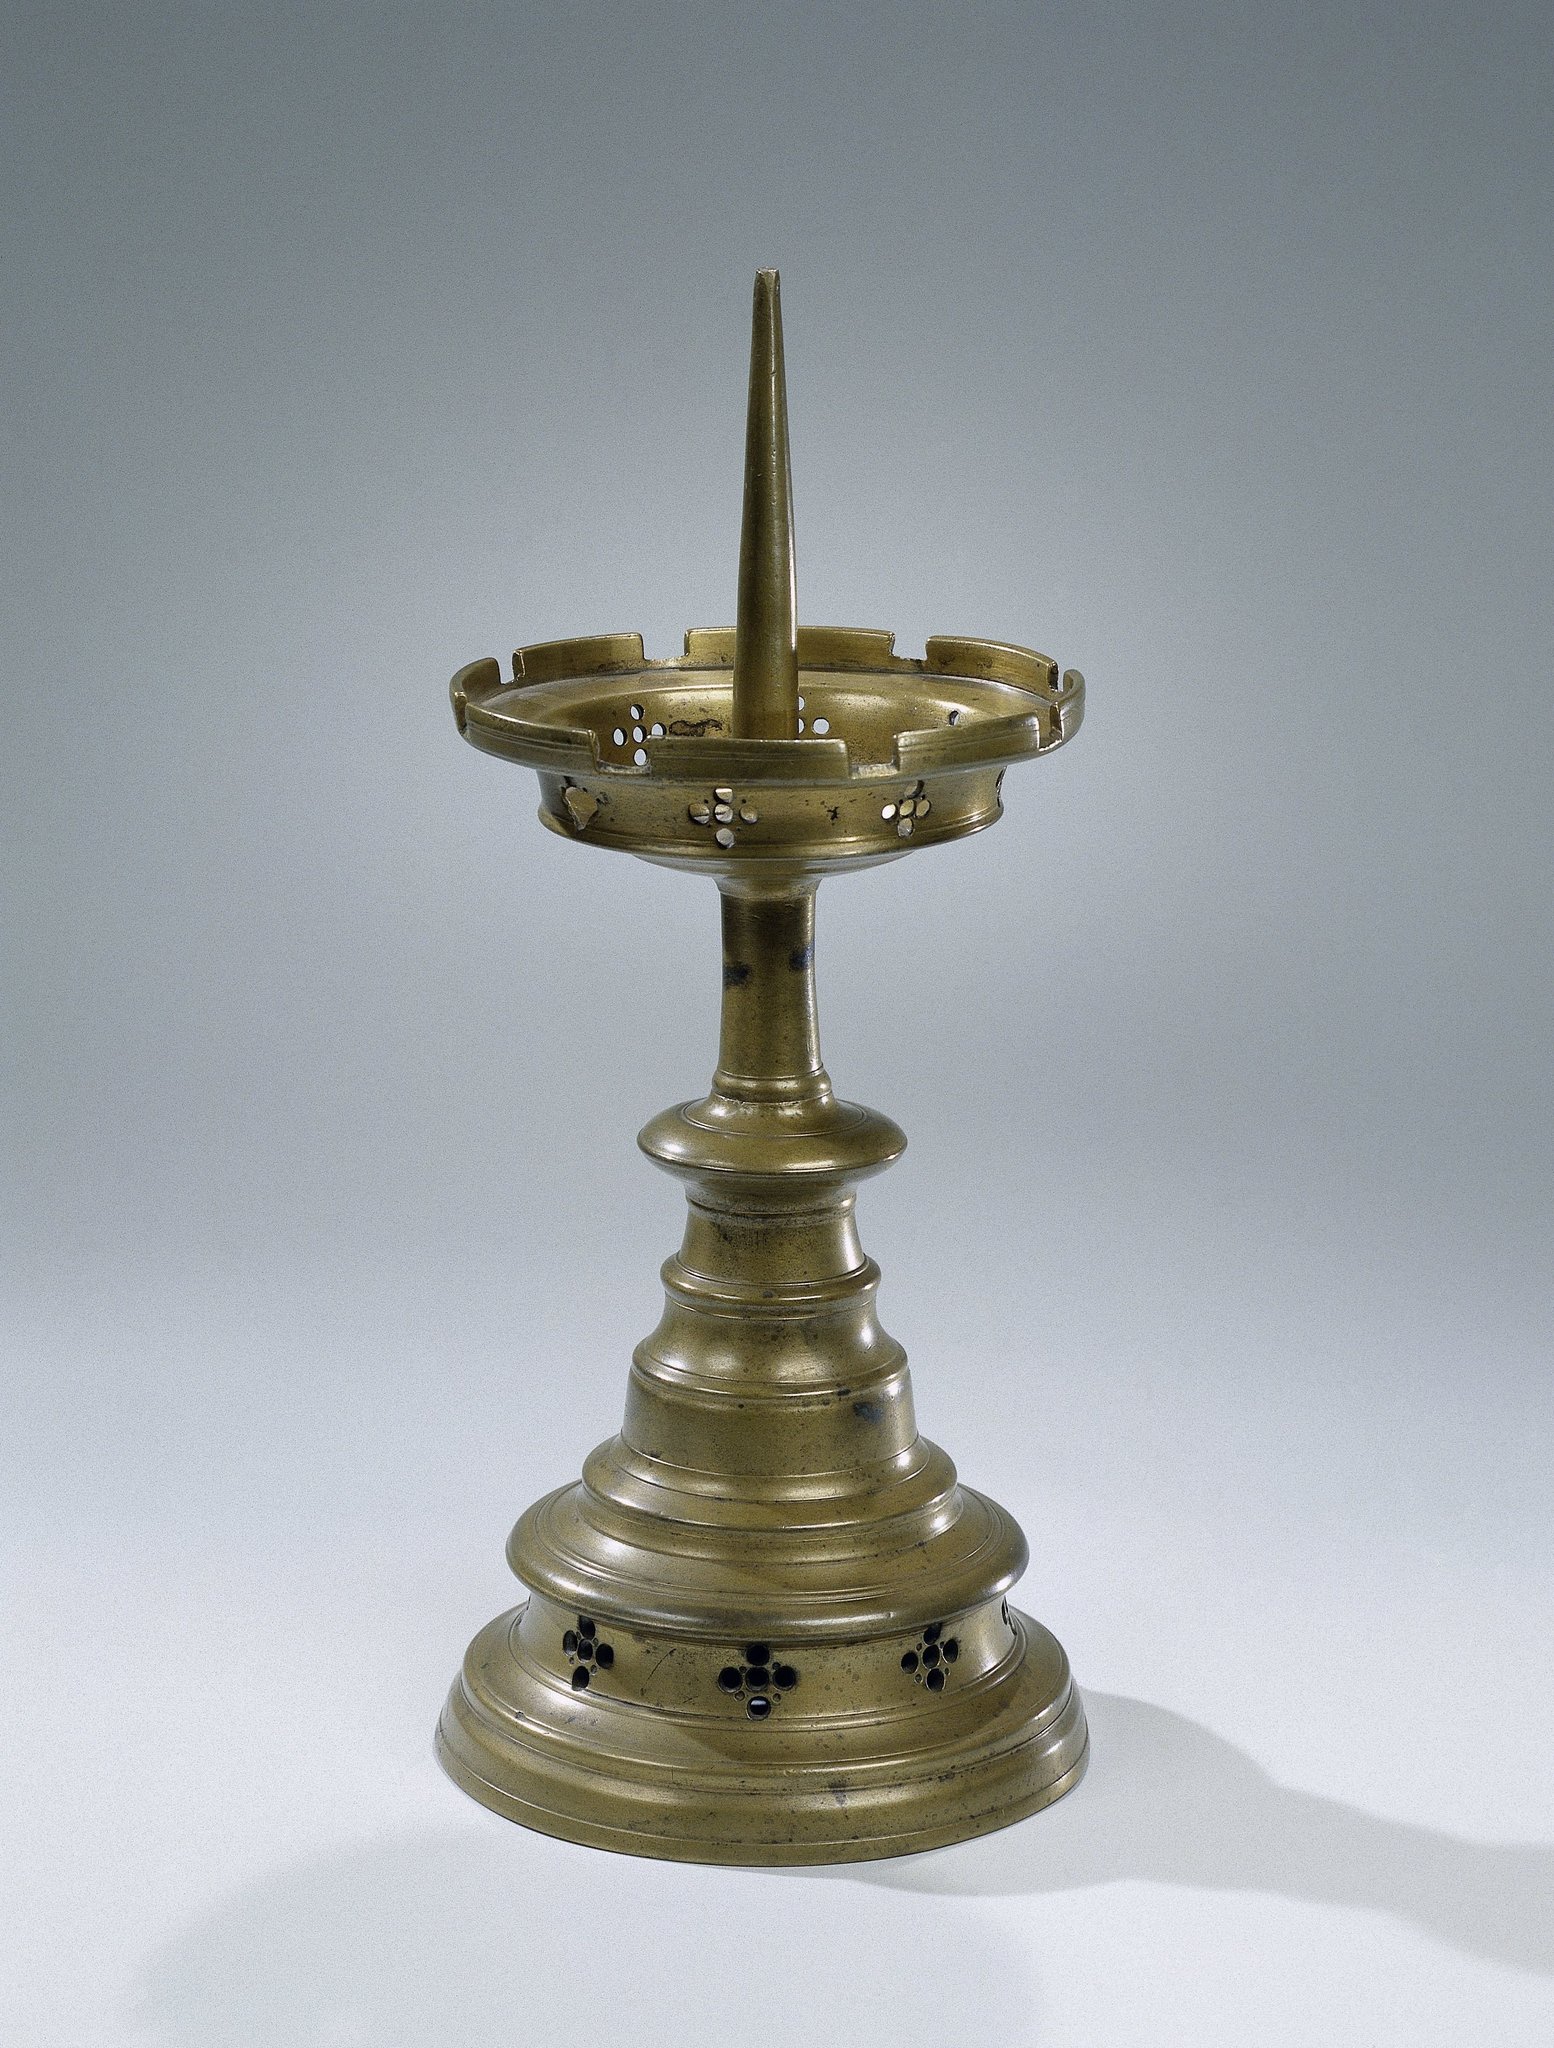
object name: candlestick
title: Kandelaar met geprofileerde voet en stam, voorzien van een kaarsenpin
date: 1425-1475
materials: brass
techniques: casting, punching, turning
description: Candlestick. Brass. Netherlands, c. 1400 - 1450.